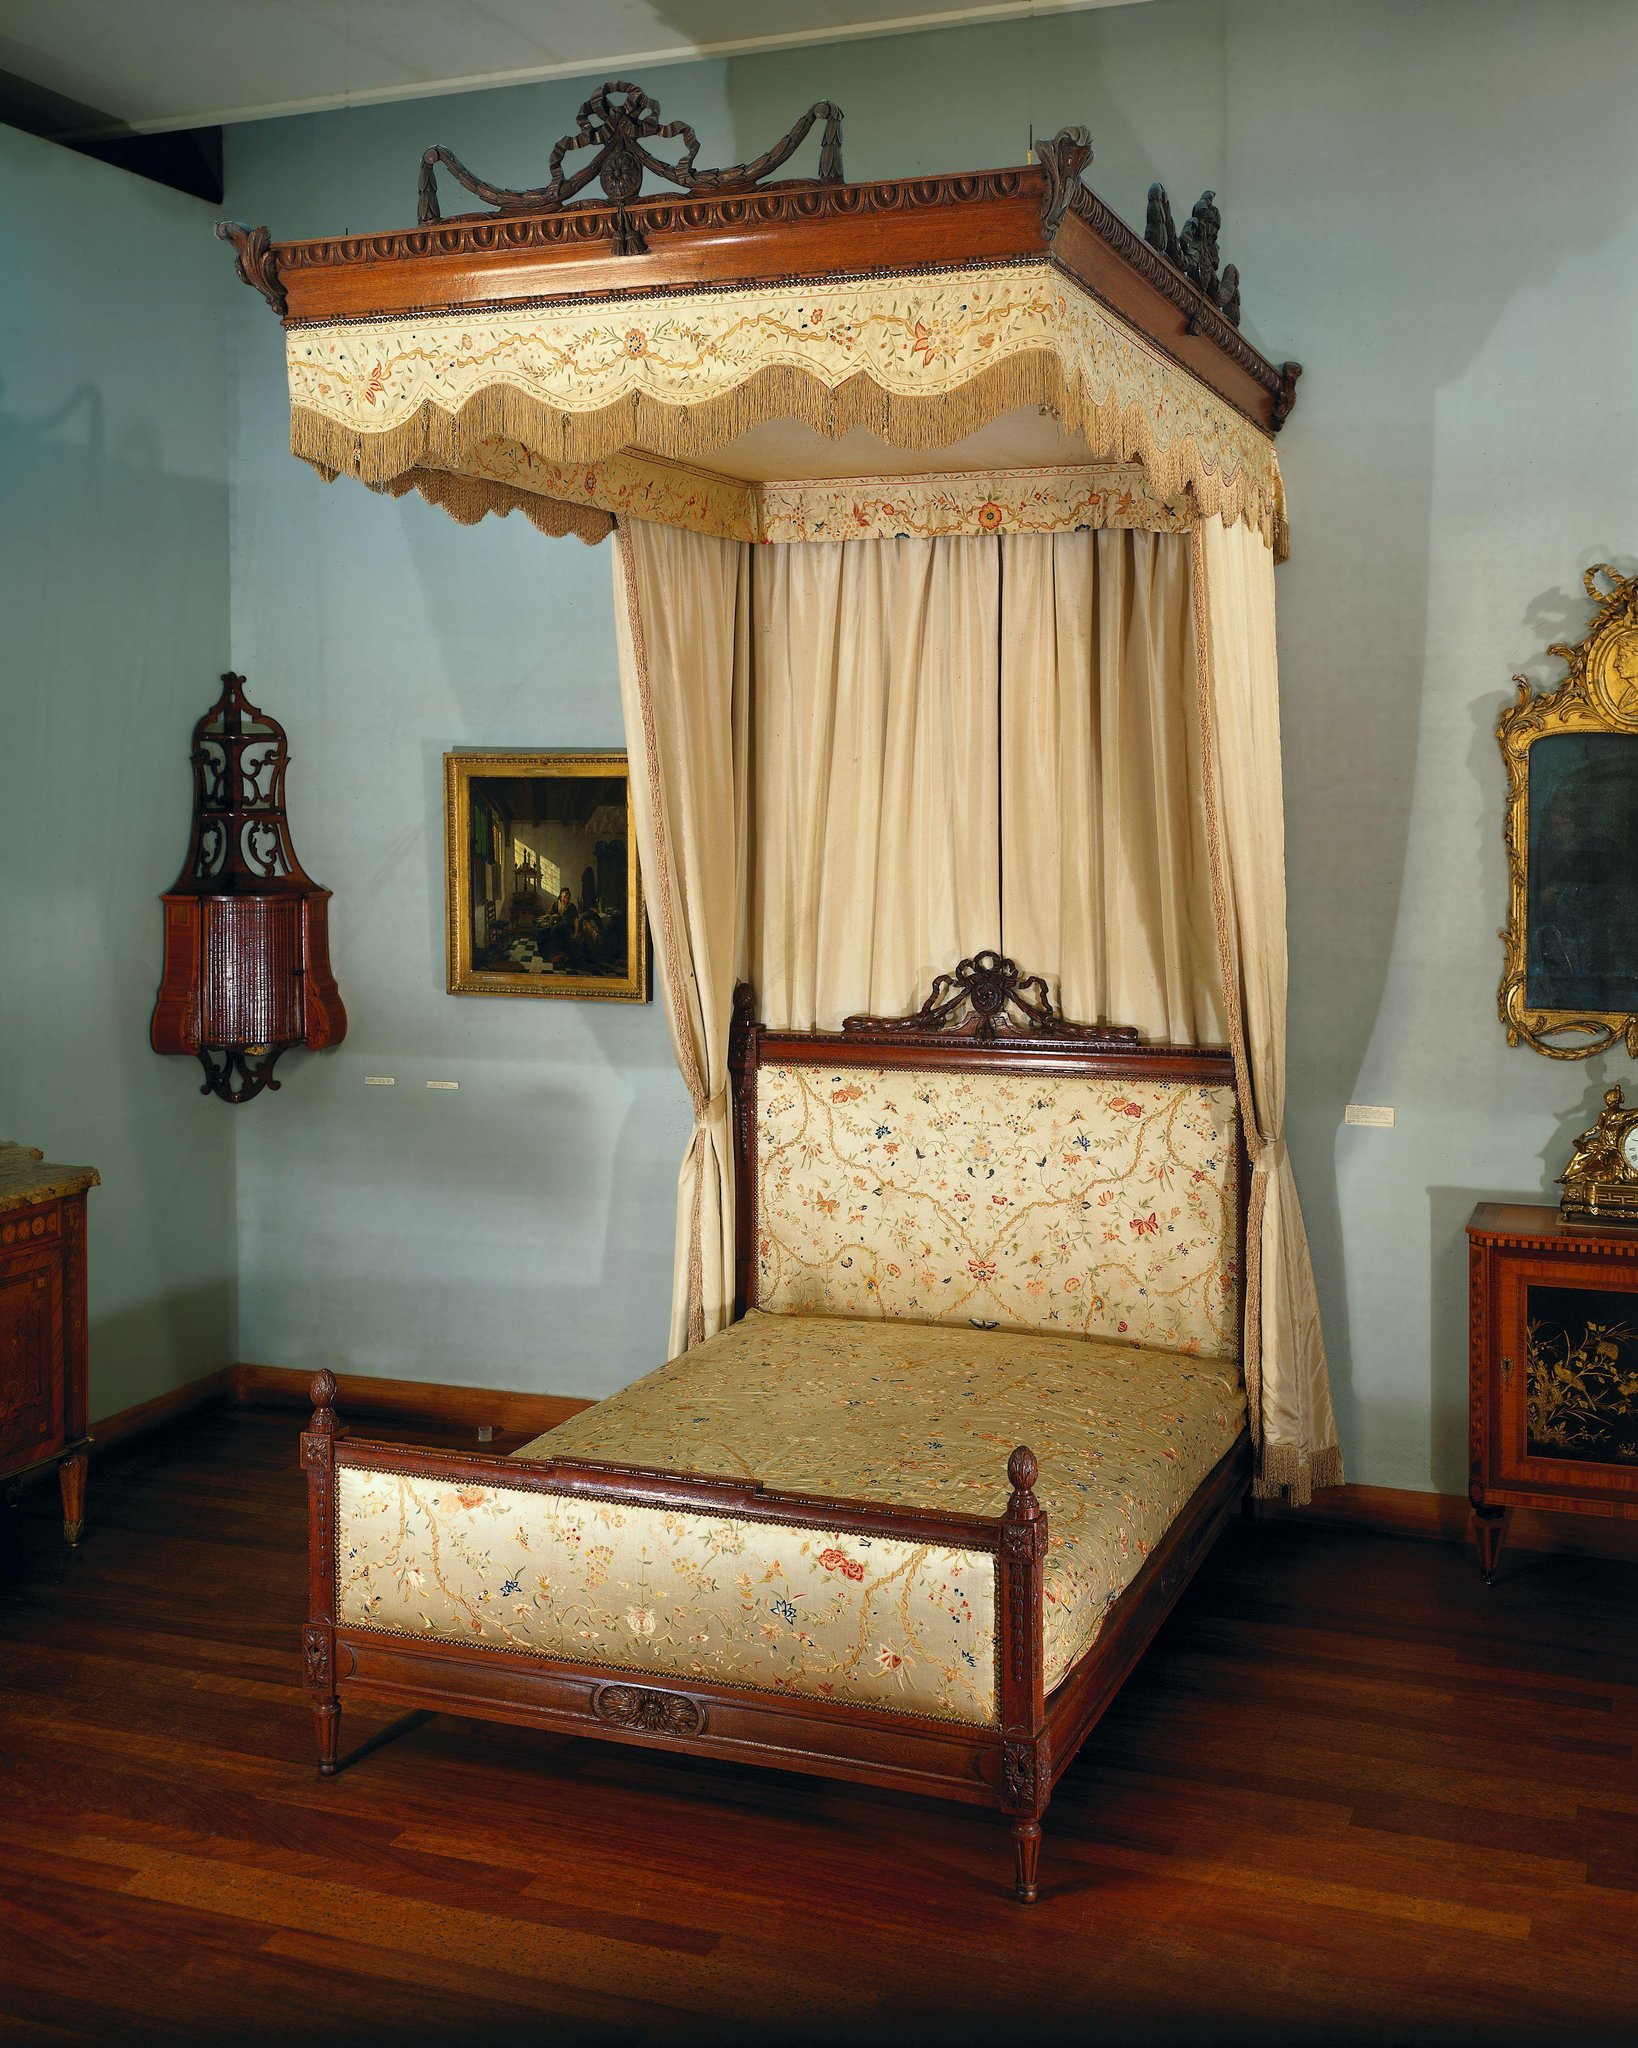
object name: textile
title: Strook, accoladevormig geschulpt, van crème-witte satijn, kleurig geborduurd met een rozet en slingerende rank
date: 1750-1800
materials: silk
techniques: embroidered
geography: china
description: Strook, accoladevormig geschulpt, van crème-witte satijn, kleurig geborduurd met een rozet en slingerende rank. Vormt een pendant met een tweede exemplaar. Chinese zijde.